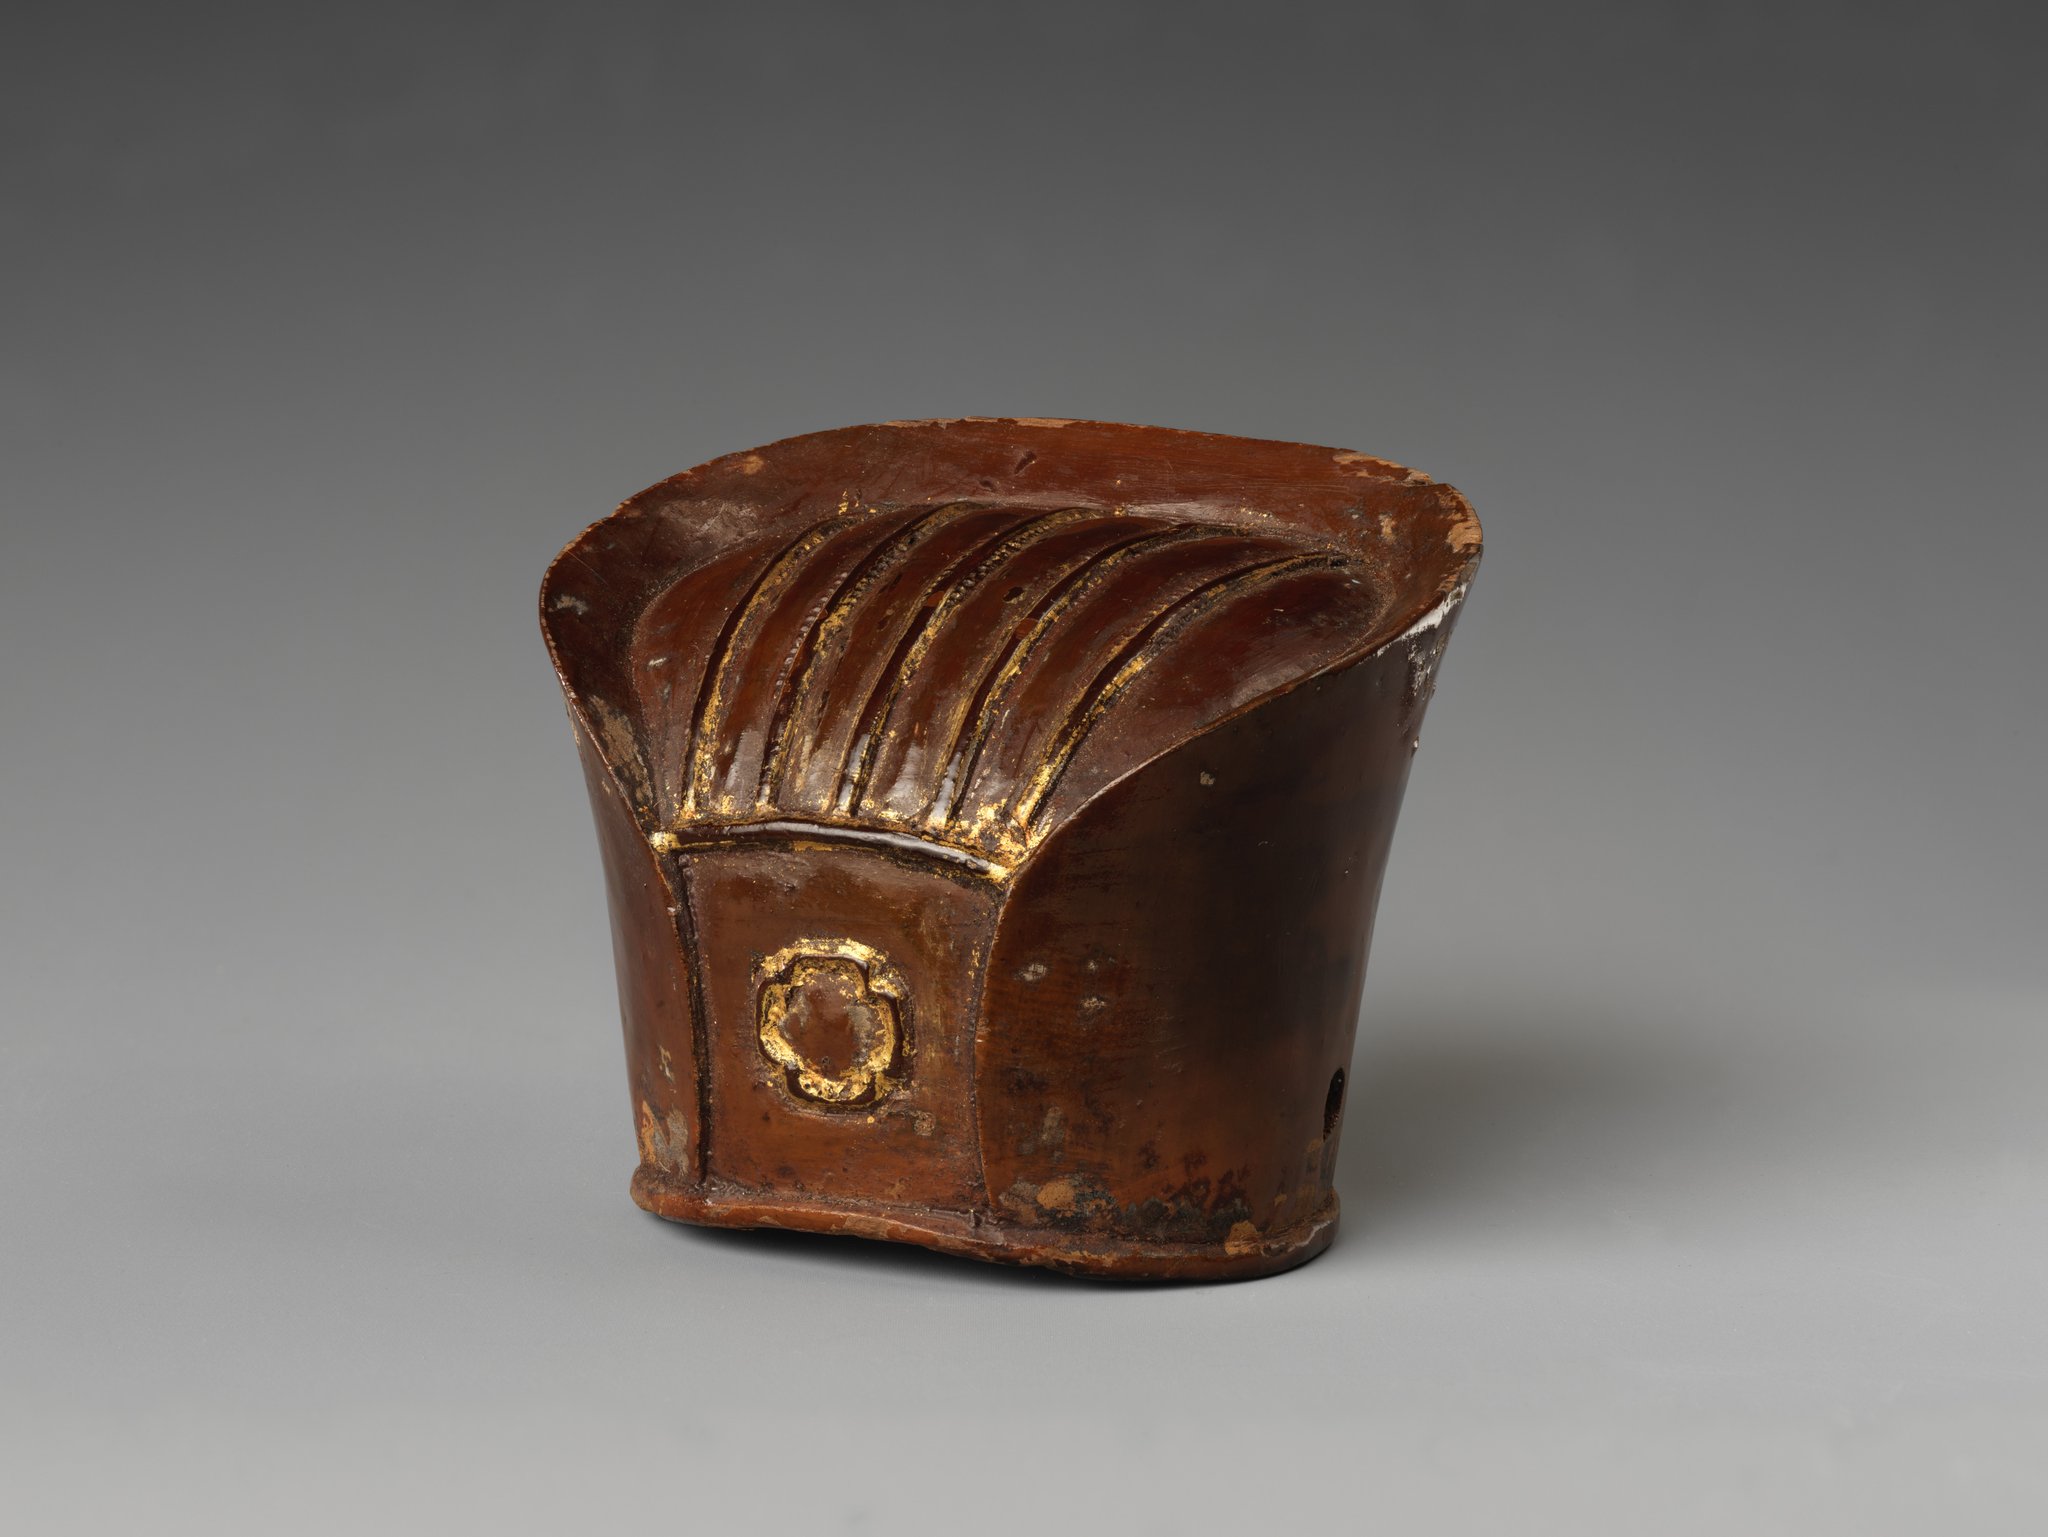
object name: hair ornament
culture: chinese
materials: gilt, lacquer, wood